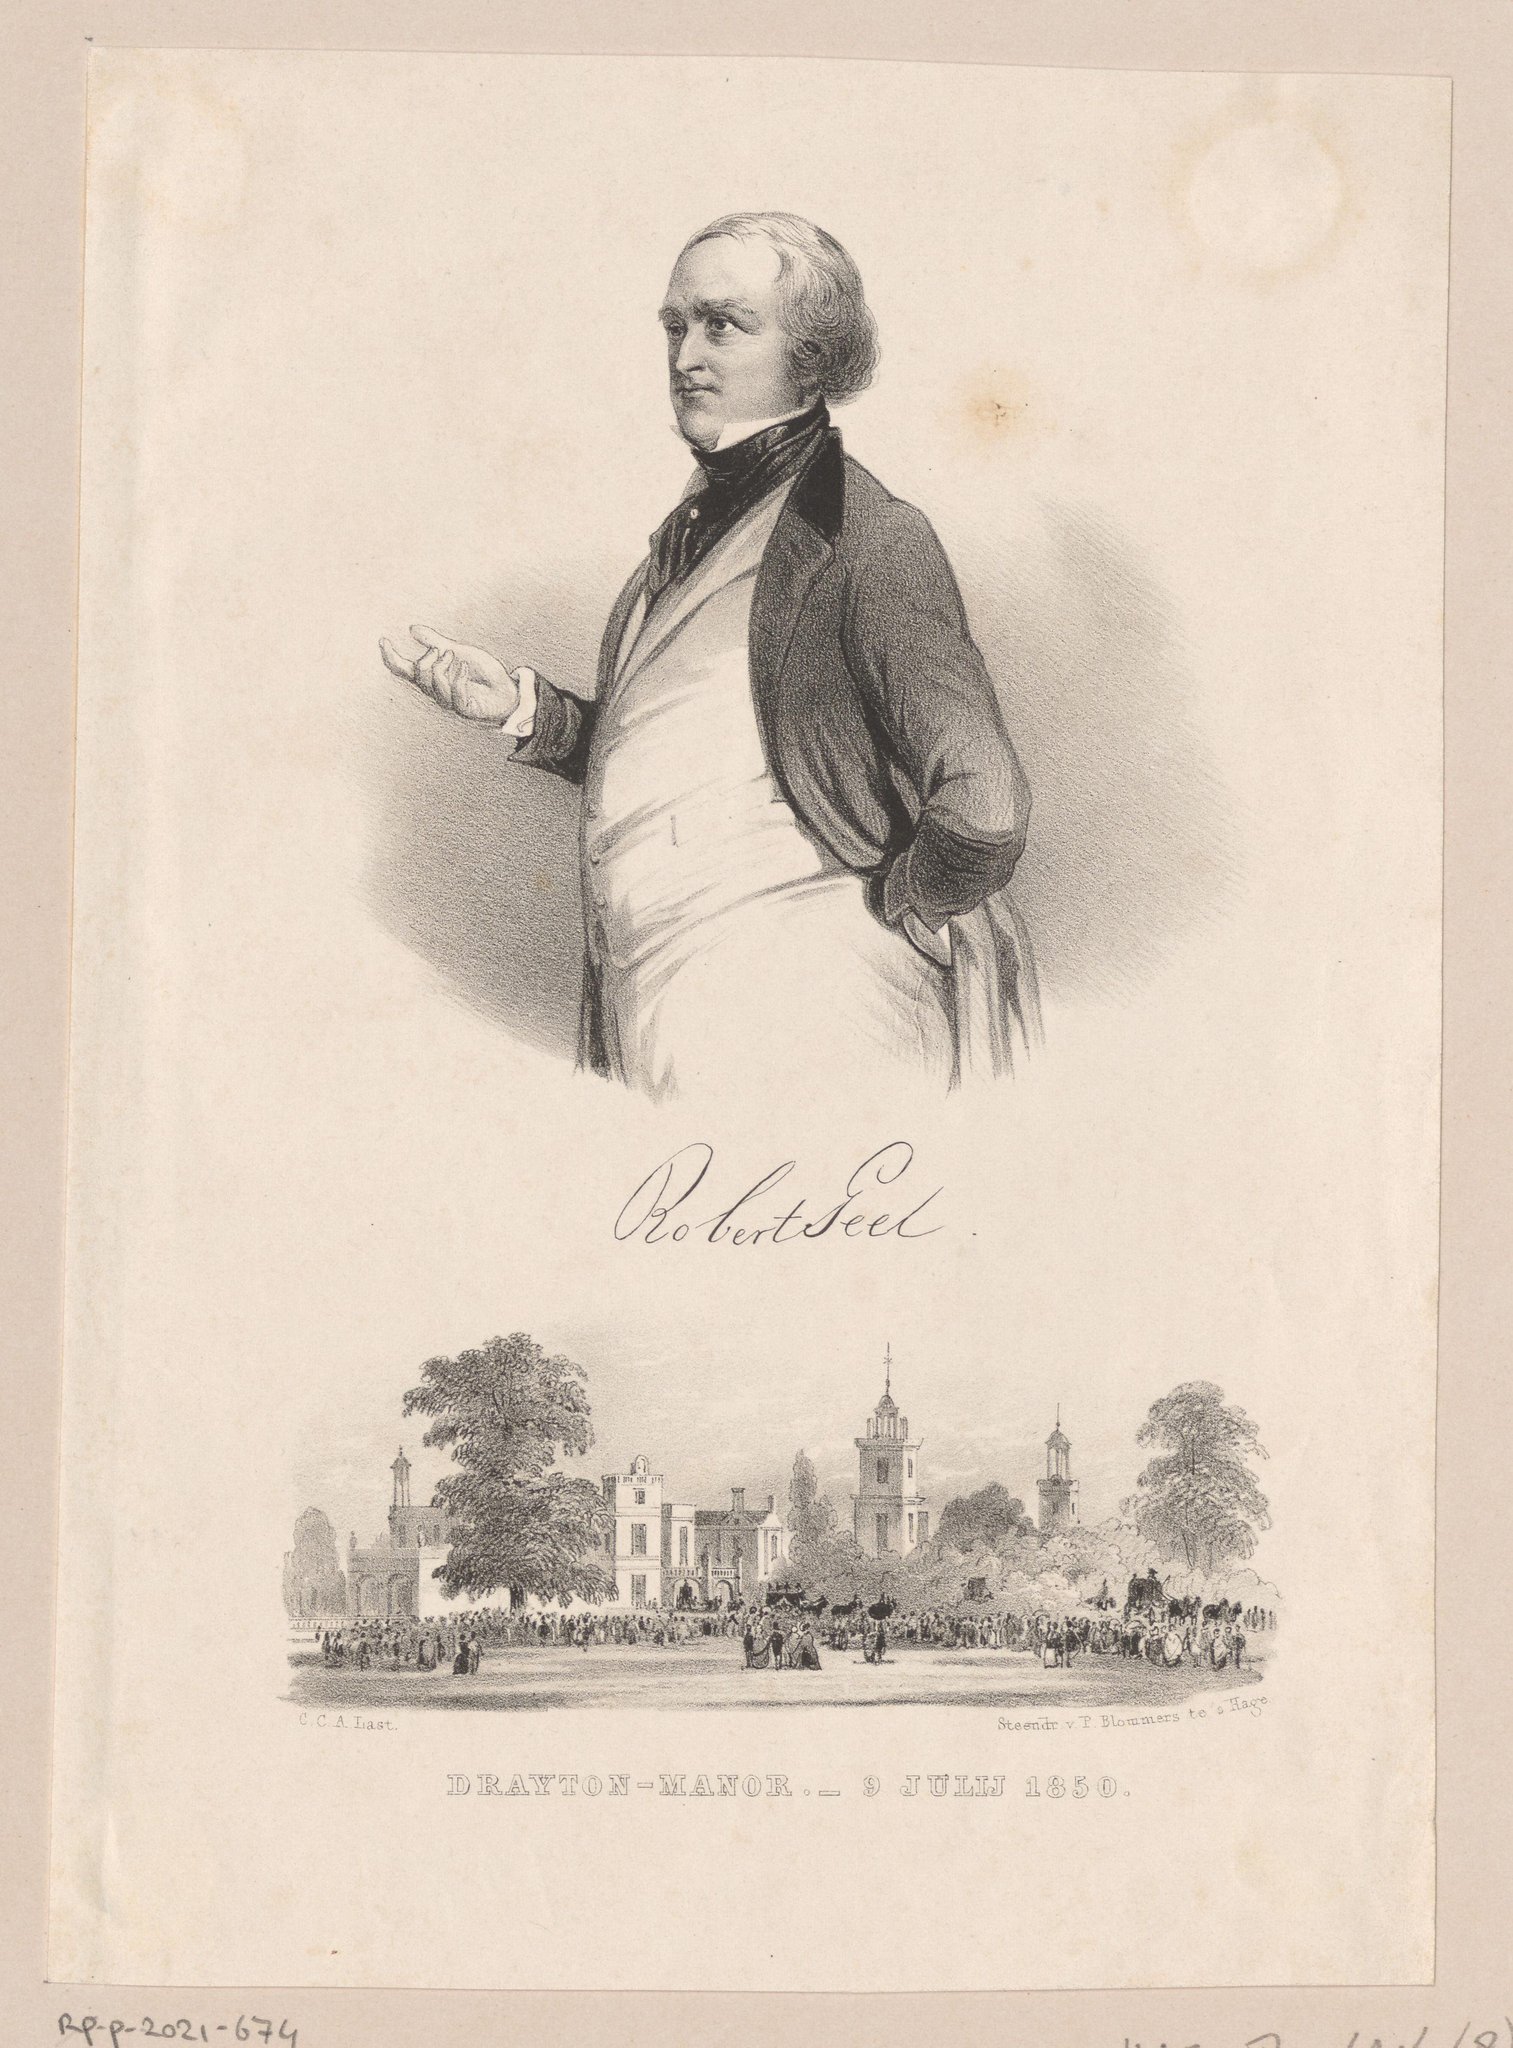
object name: print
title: Portret van Robert Peel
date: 1850-1876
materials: paper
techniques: lithograph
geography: the hague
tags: adult man, historical persons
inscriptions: collector's mark: Lugt 2228